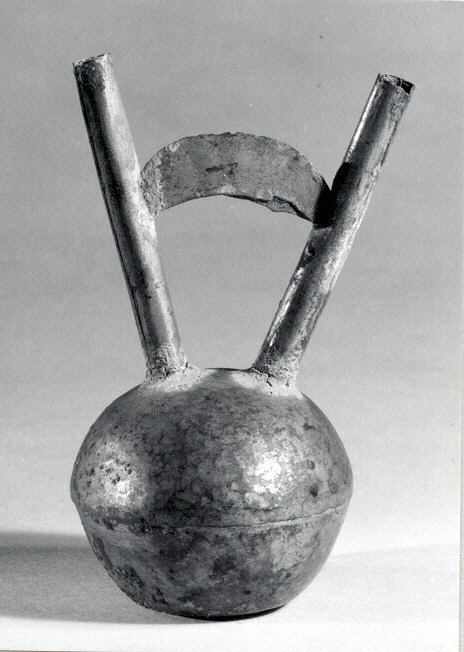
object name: bottle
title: Double Spouted Miniature Silver Vessel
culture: chancay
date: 1001-1200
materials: silver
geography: peru